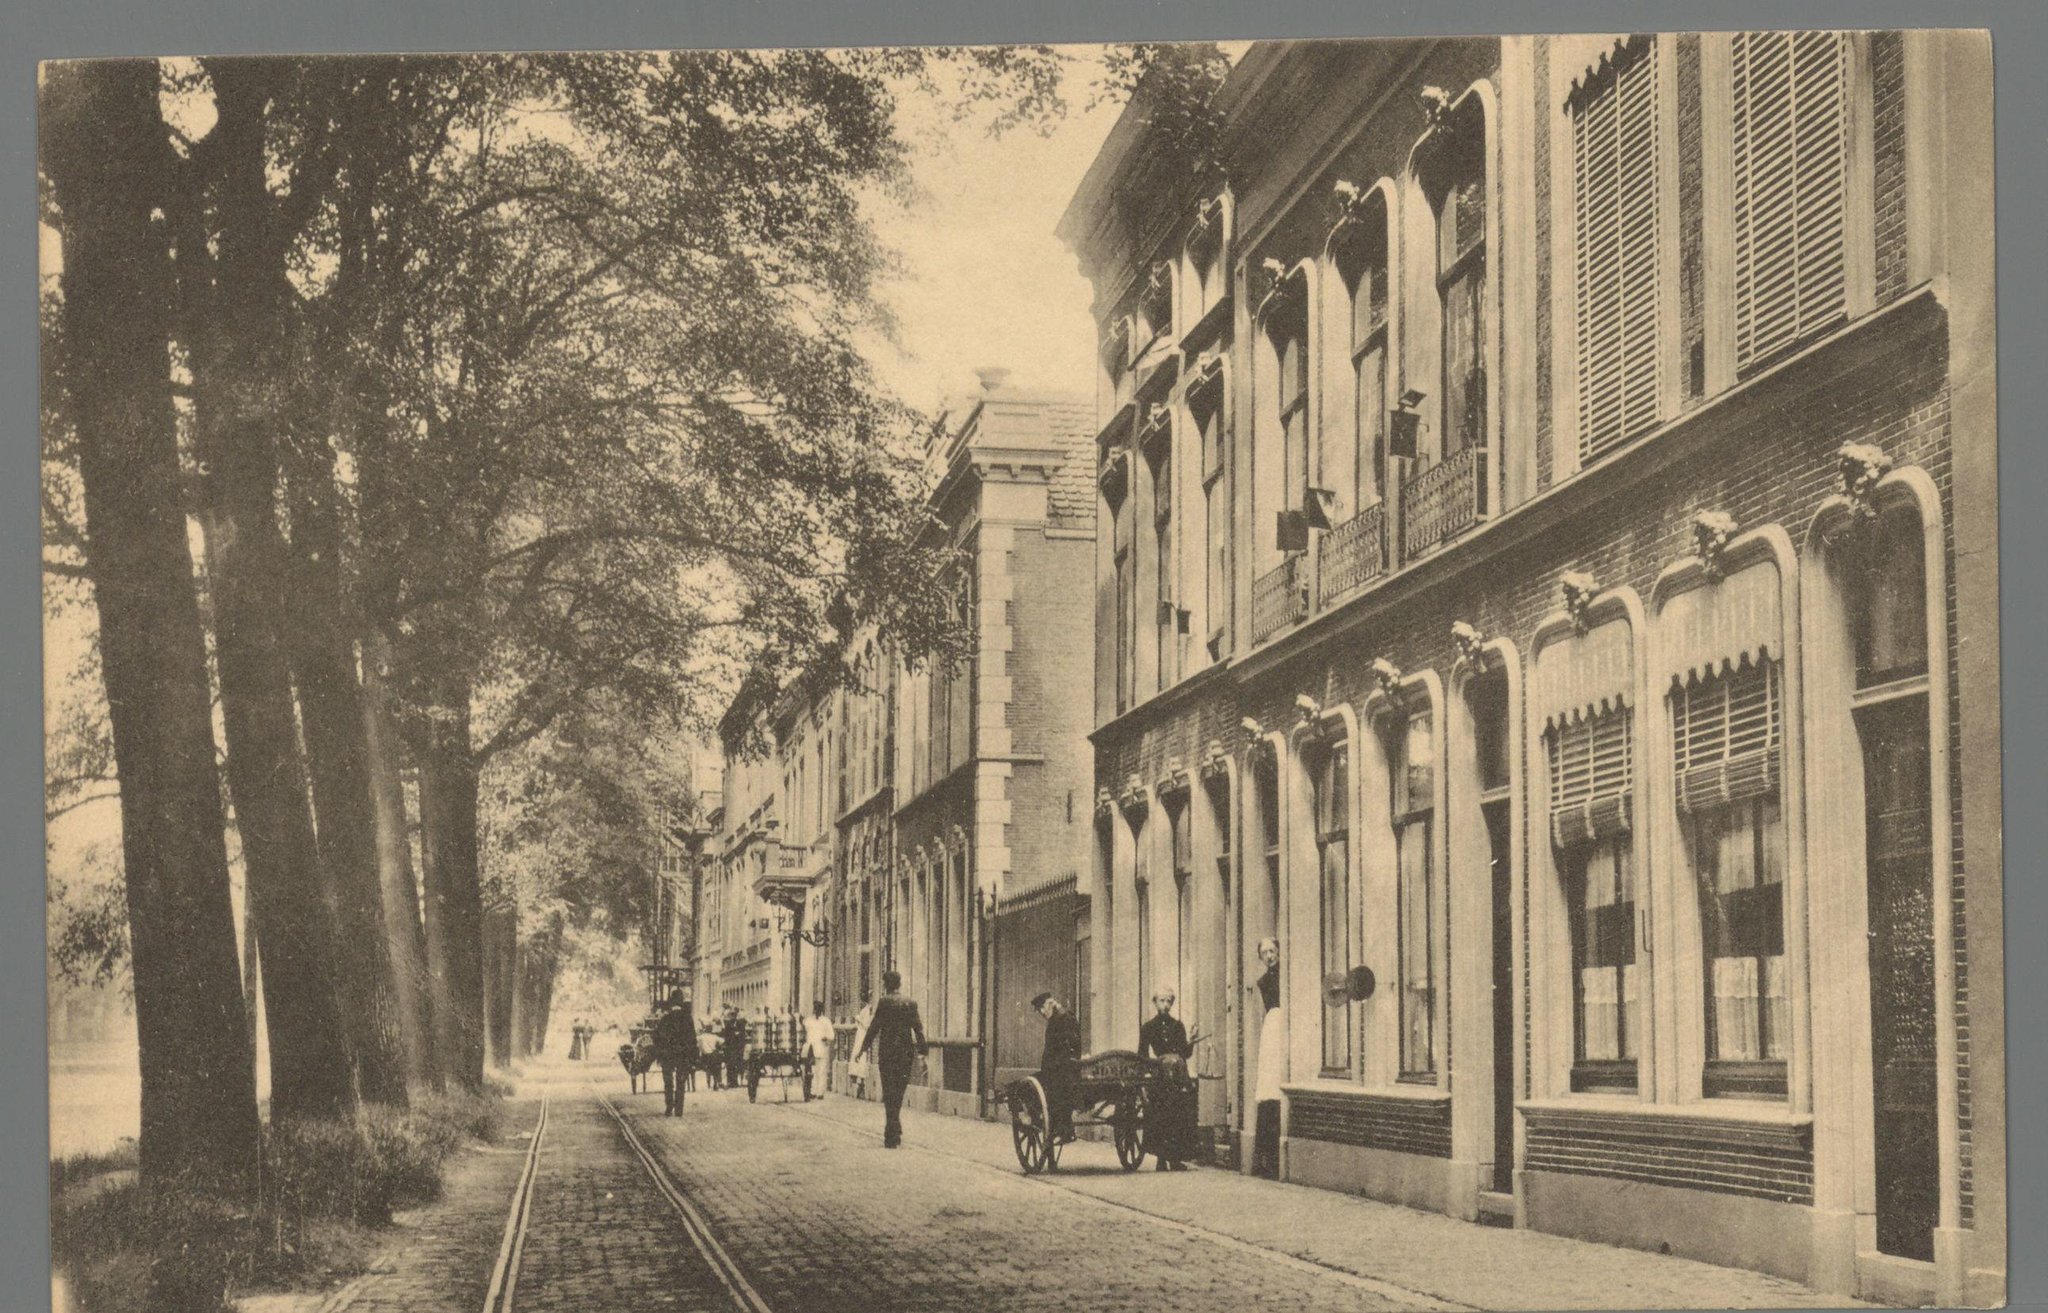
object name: ansichtkaart, prentbriefkaart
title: Fluweelen Singel, Gouda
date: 1905-1930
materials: cardboard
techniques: photograph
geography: gouda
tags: street, gouda